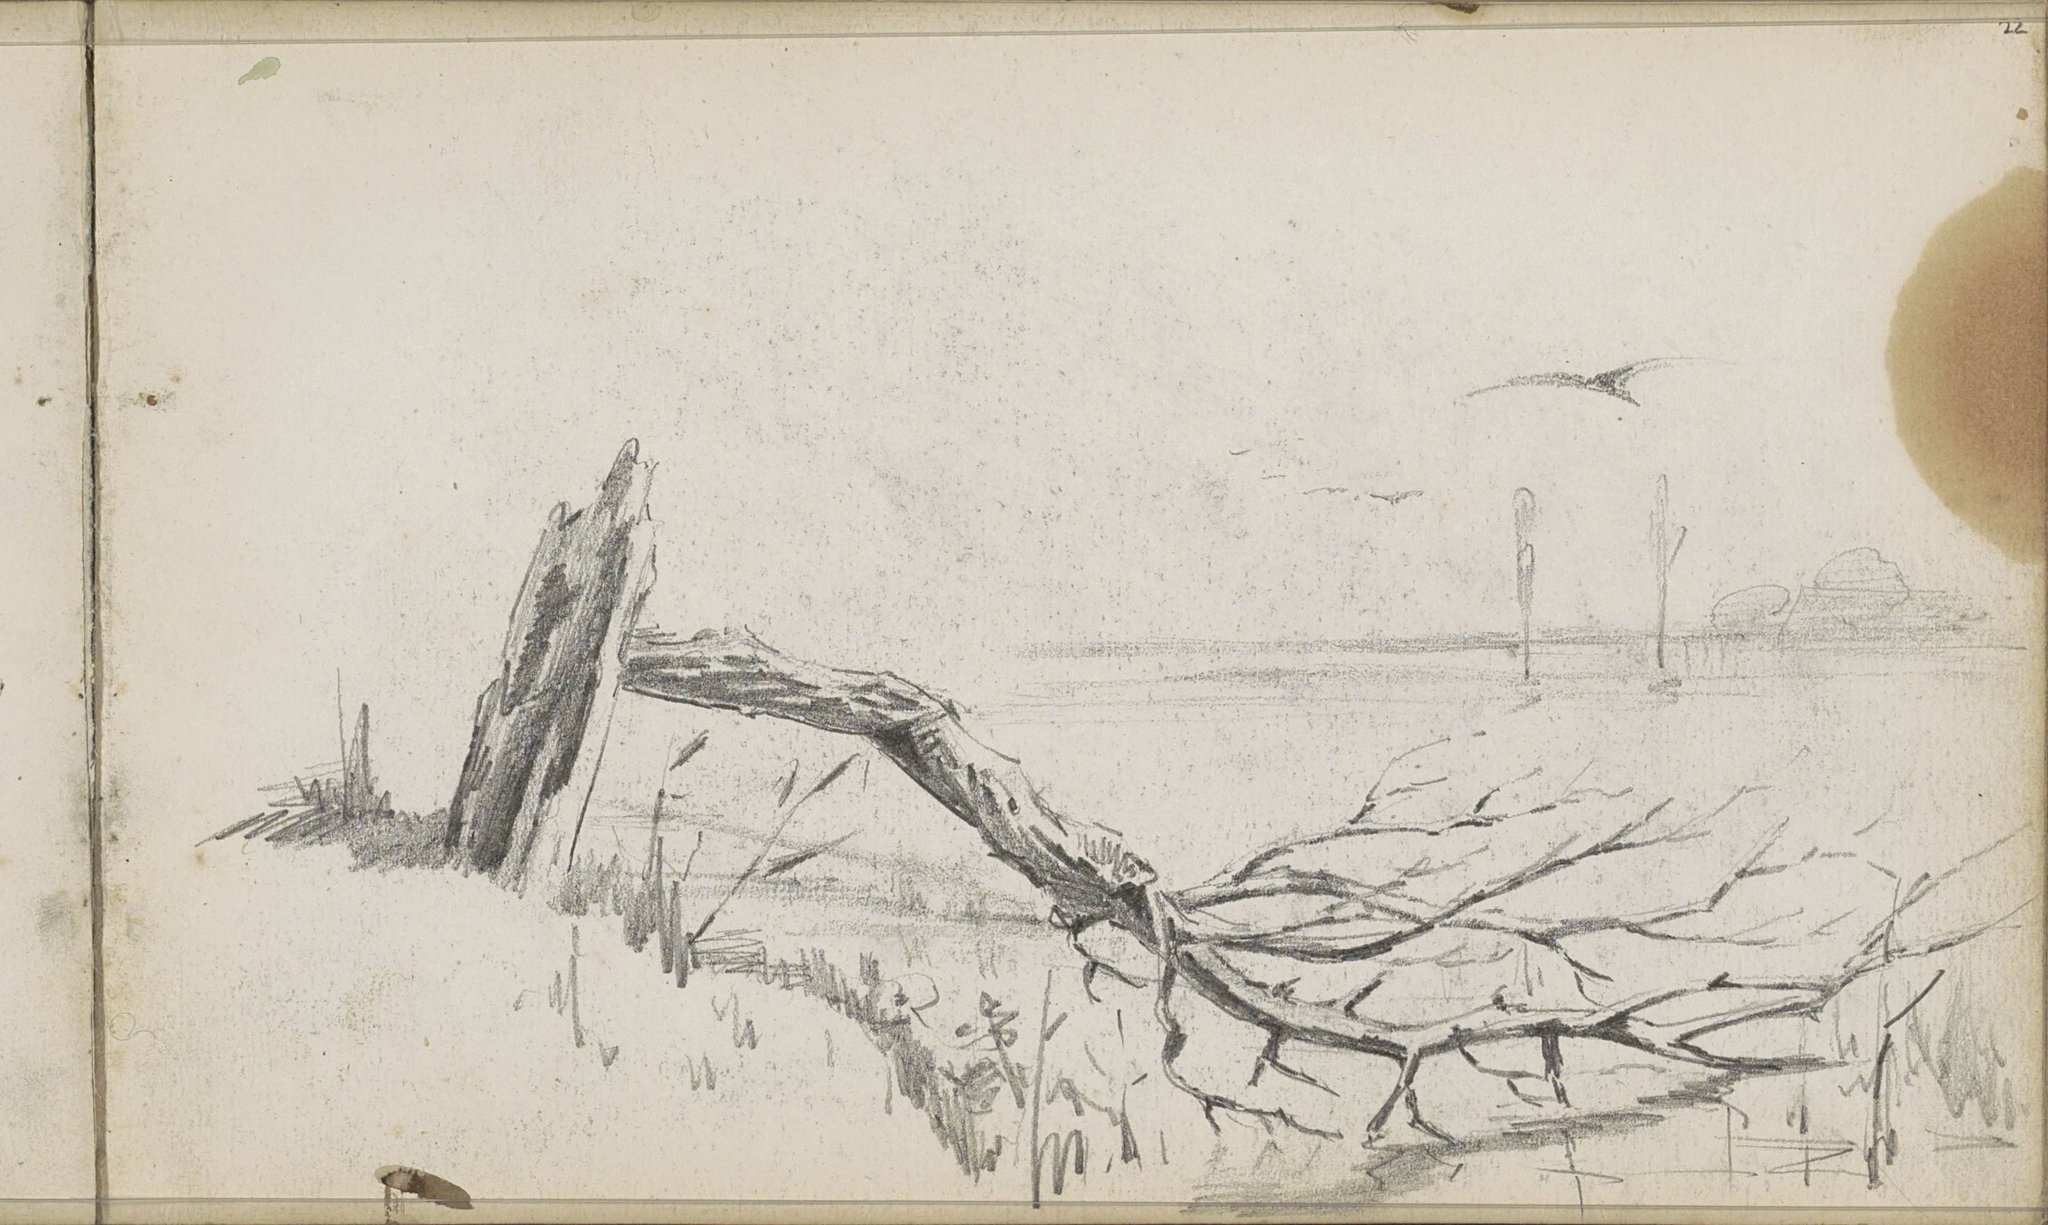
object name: sketchbook leaf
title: Omgevallen boom aan een waterkant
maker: willem cornelis rip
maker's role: draughtsman, painter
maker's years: 1856-1922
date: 1876-1877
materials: paper, pencil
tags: trees, landscapes with waters, waterscapes, seascapes (in the temperate zone)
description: Blad 22 recto uit een schetsboek met 41 bladen.